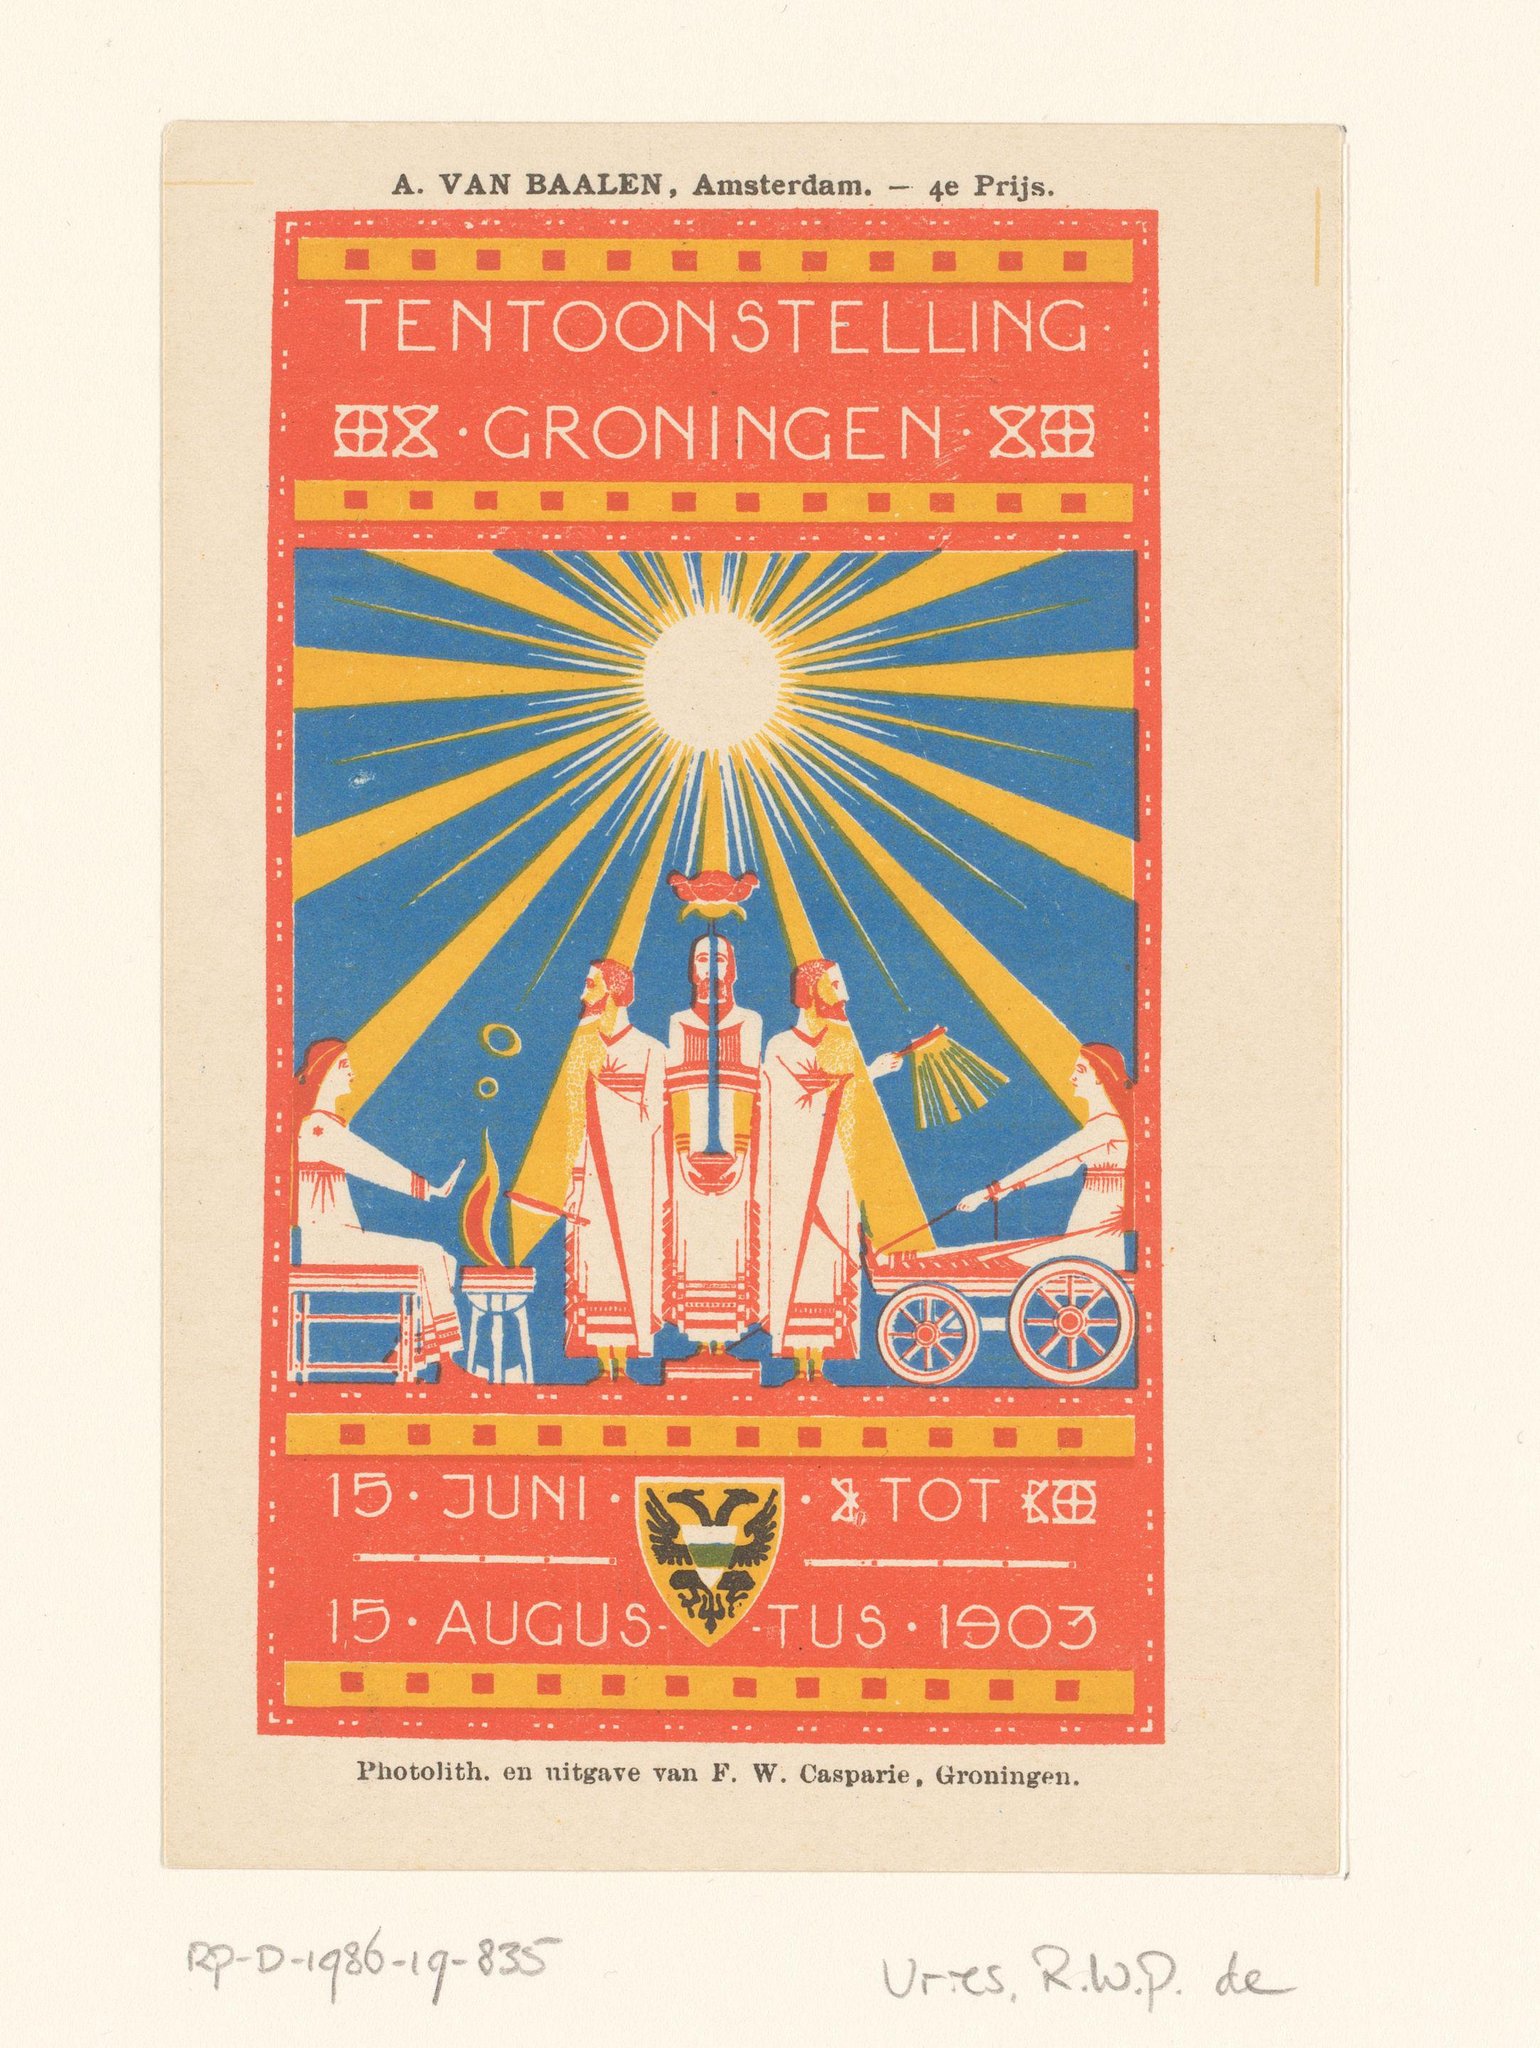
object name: ansichtkaart, prentbriefkaart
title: Prentbriefkaart van de tentoonstelling voor nijverheid en kunst te Groningen in 1903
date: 1903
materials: paper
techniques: photolithography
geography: groningen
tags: light, open fire (in general), (farm) wagon, freight wagon, cart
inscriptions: date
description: Drie priesters en twee vrouwen die verlichting, verwarming en vervoer verbeelden.